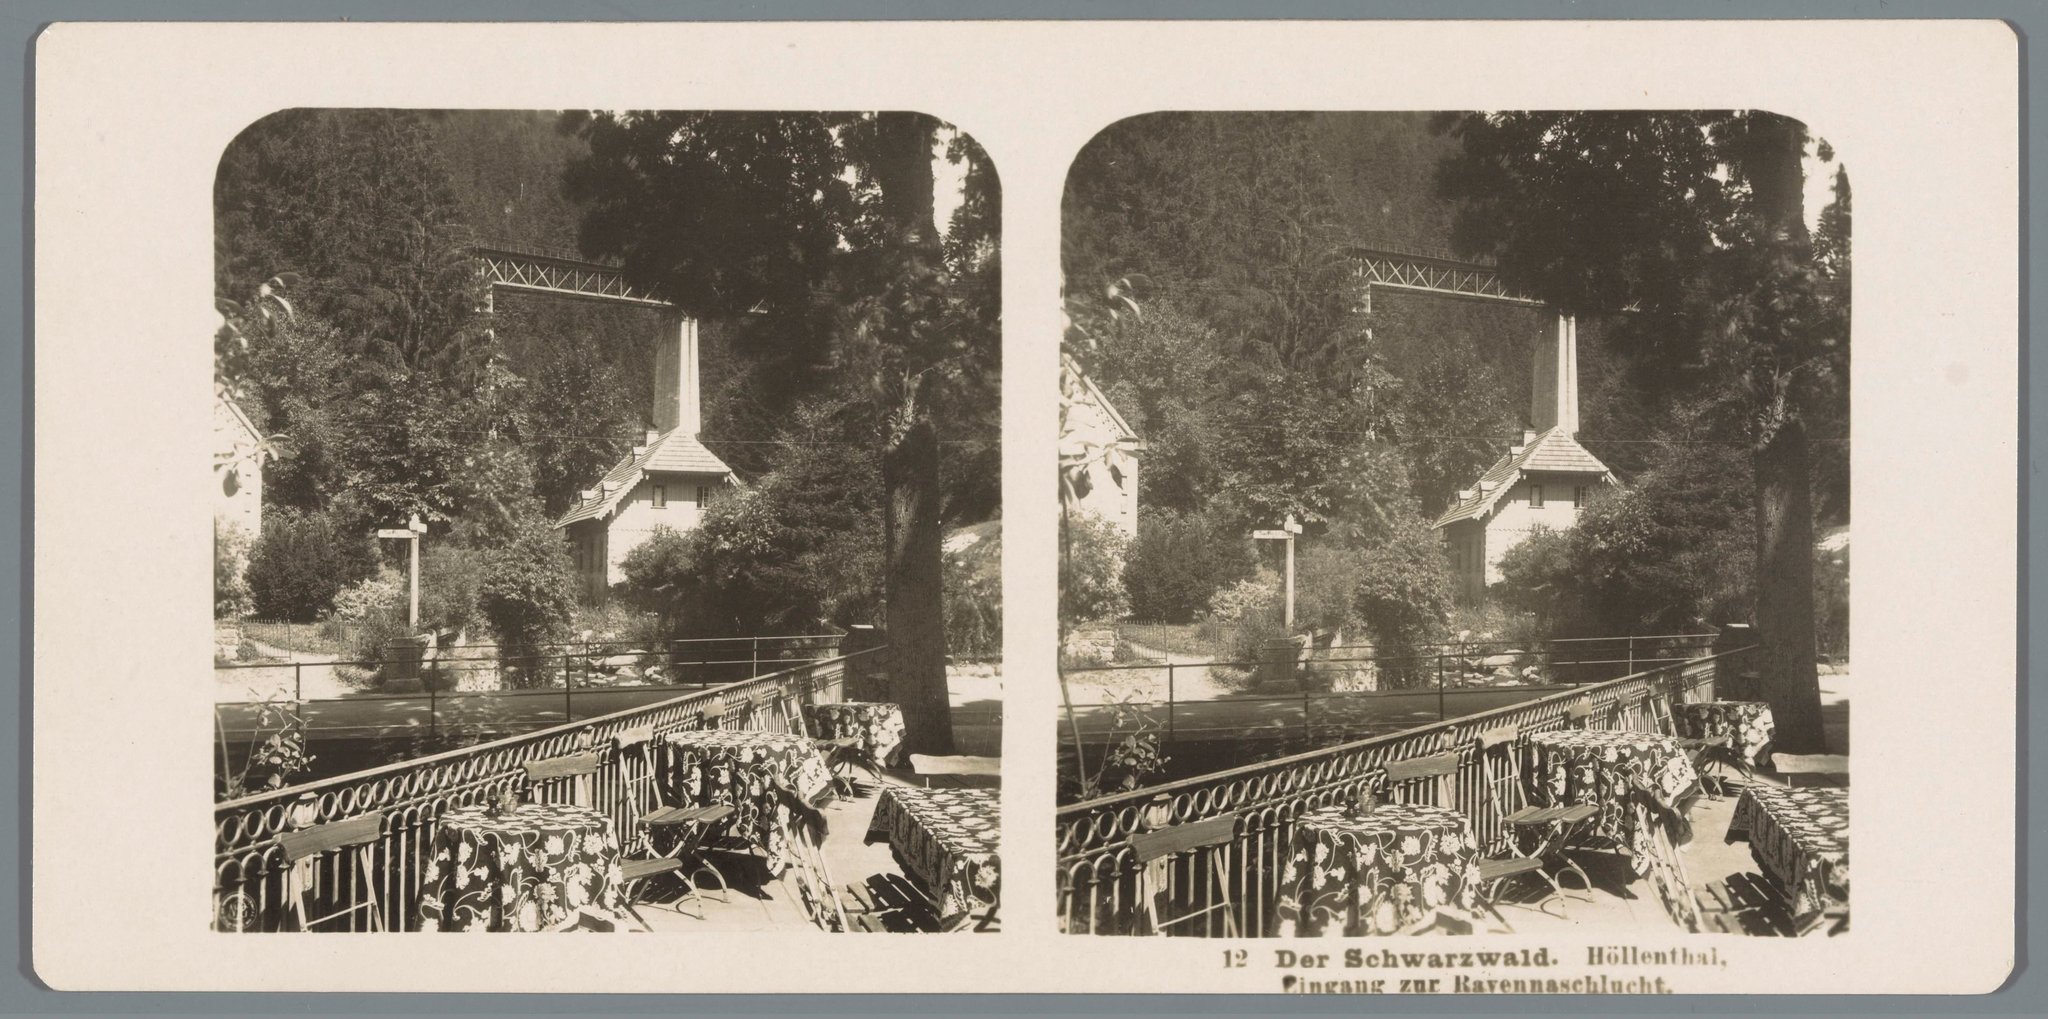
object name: stereograph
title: Gezicht op de ingang van de Ravennaschlucht in het Höllental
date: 1900-1910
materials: cardboard, photographic support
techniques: gelatin silver print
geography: höllental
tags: dale, valley, façade (of house or building)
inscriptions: inscription: ‘NPG’, number: ‘12’